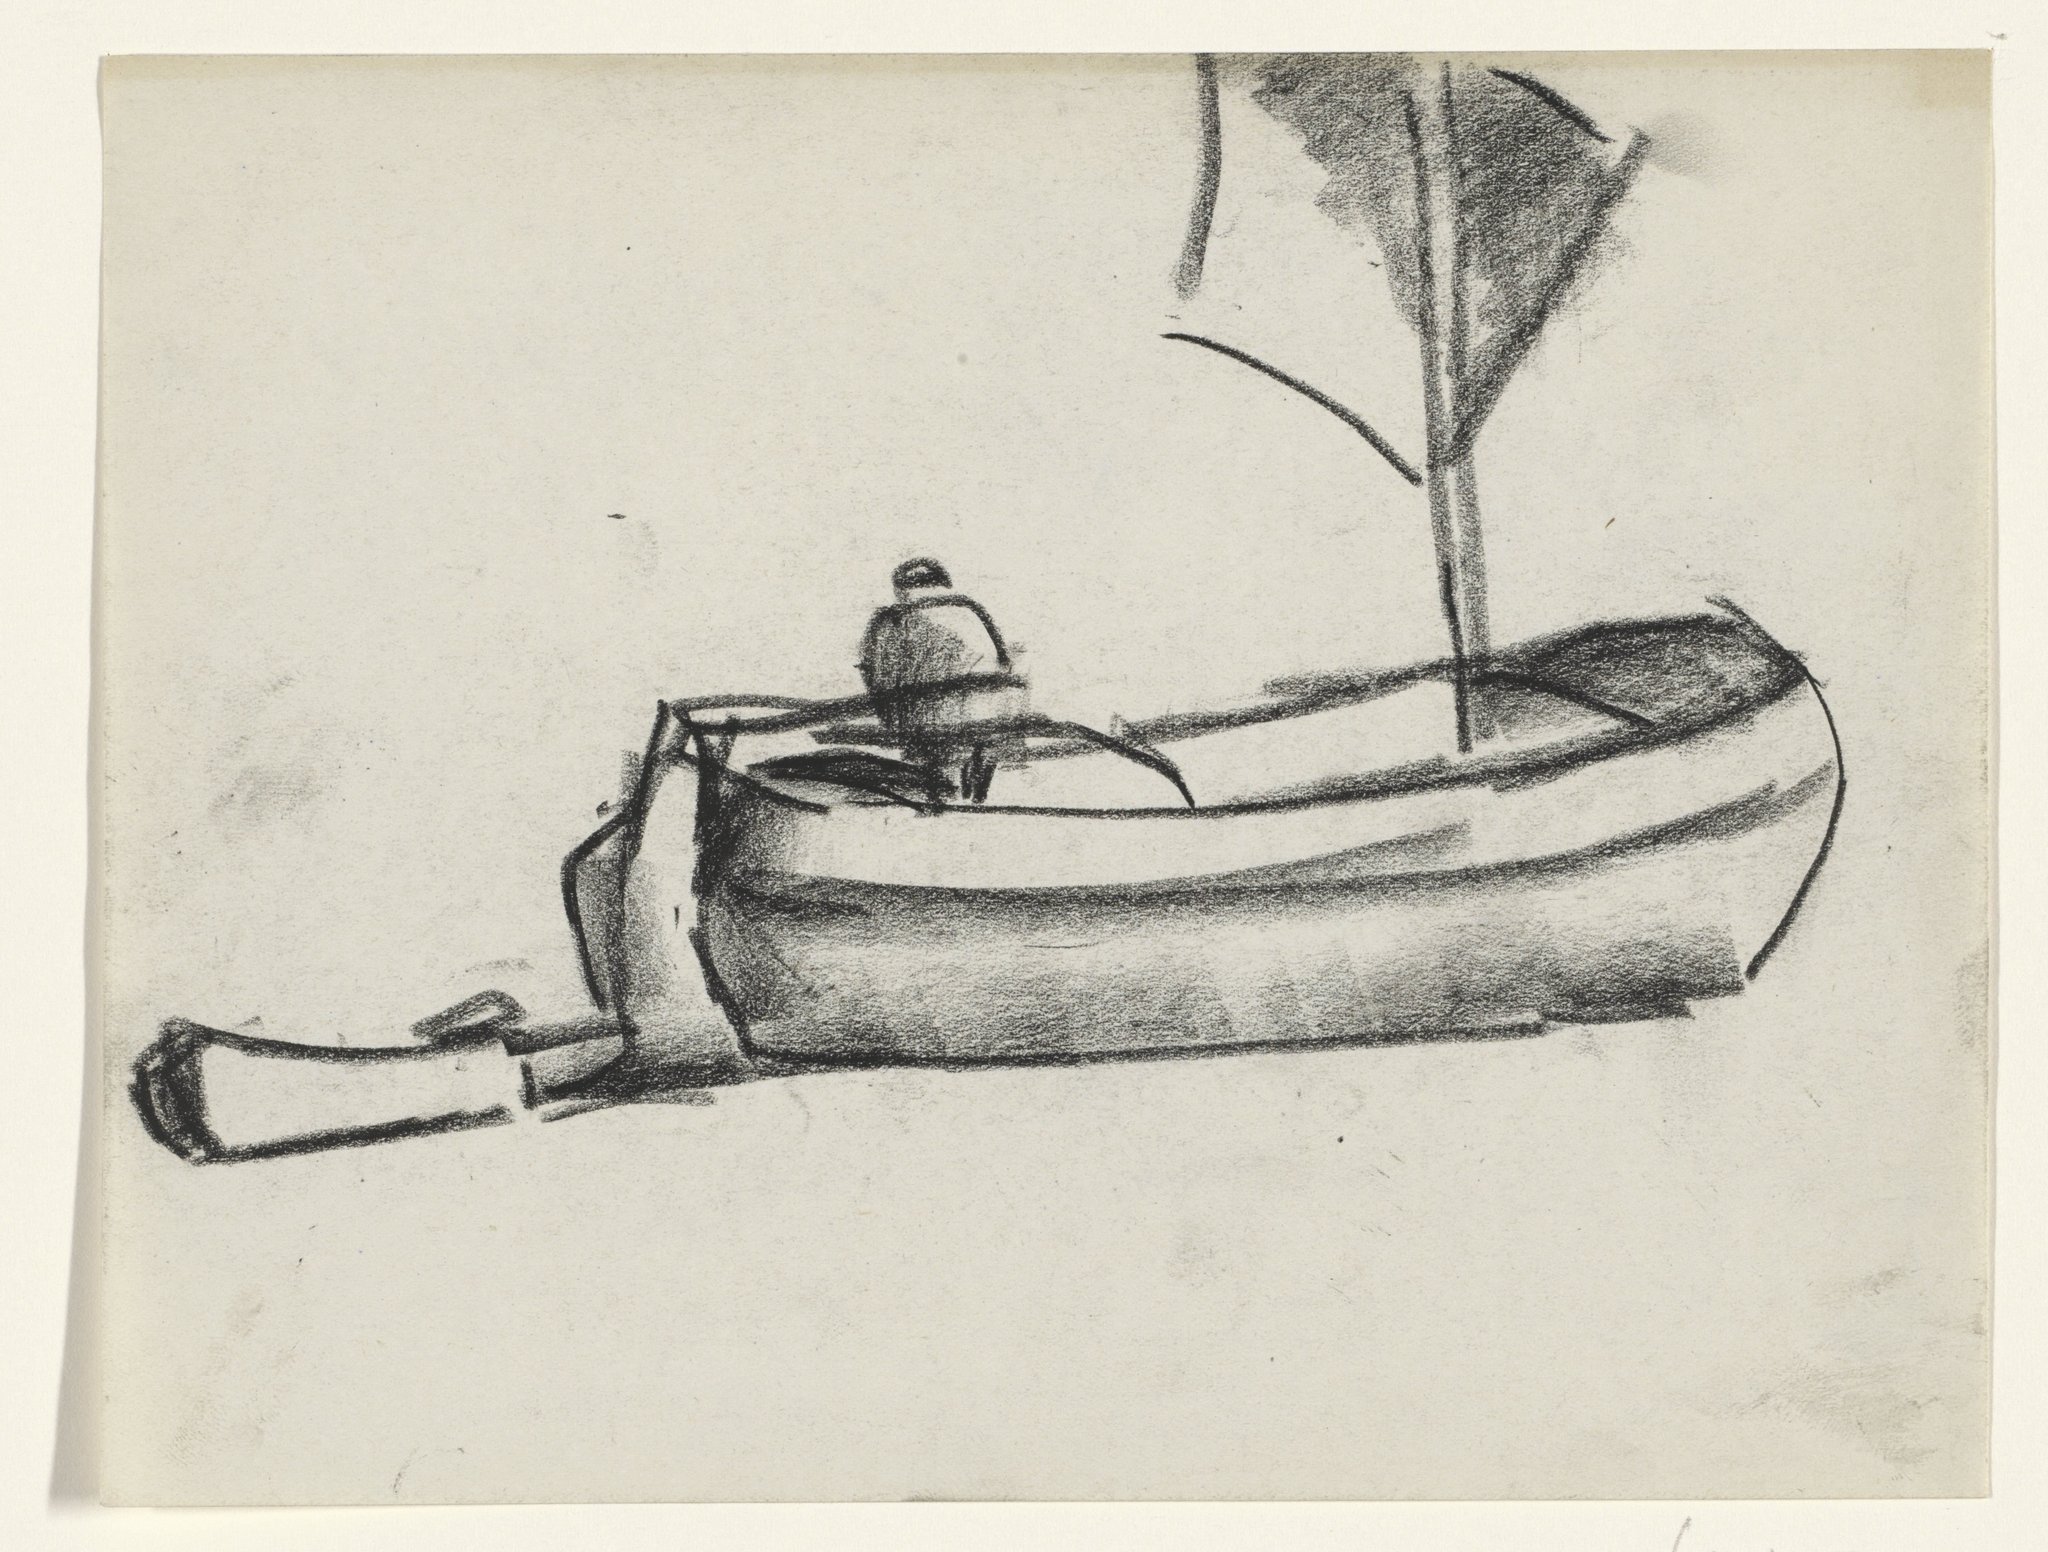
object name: drawing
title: Zeilschip met een man aan het roer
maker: leo gestel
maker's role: draughtsman, print maker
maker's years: 1881-1941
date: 1891-1941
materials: chalk, paper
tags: sailing-ship, sailing-boat, male sex; man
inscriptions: collector's mark: Lugt 2228